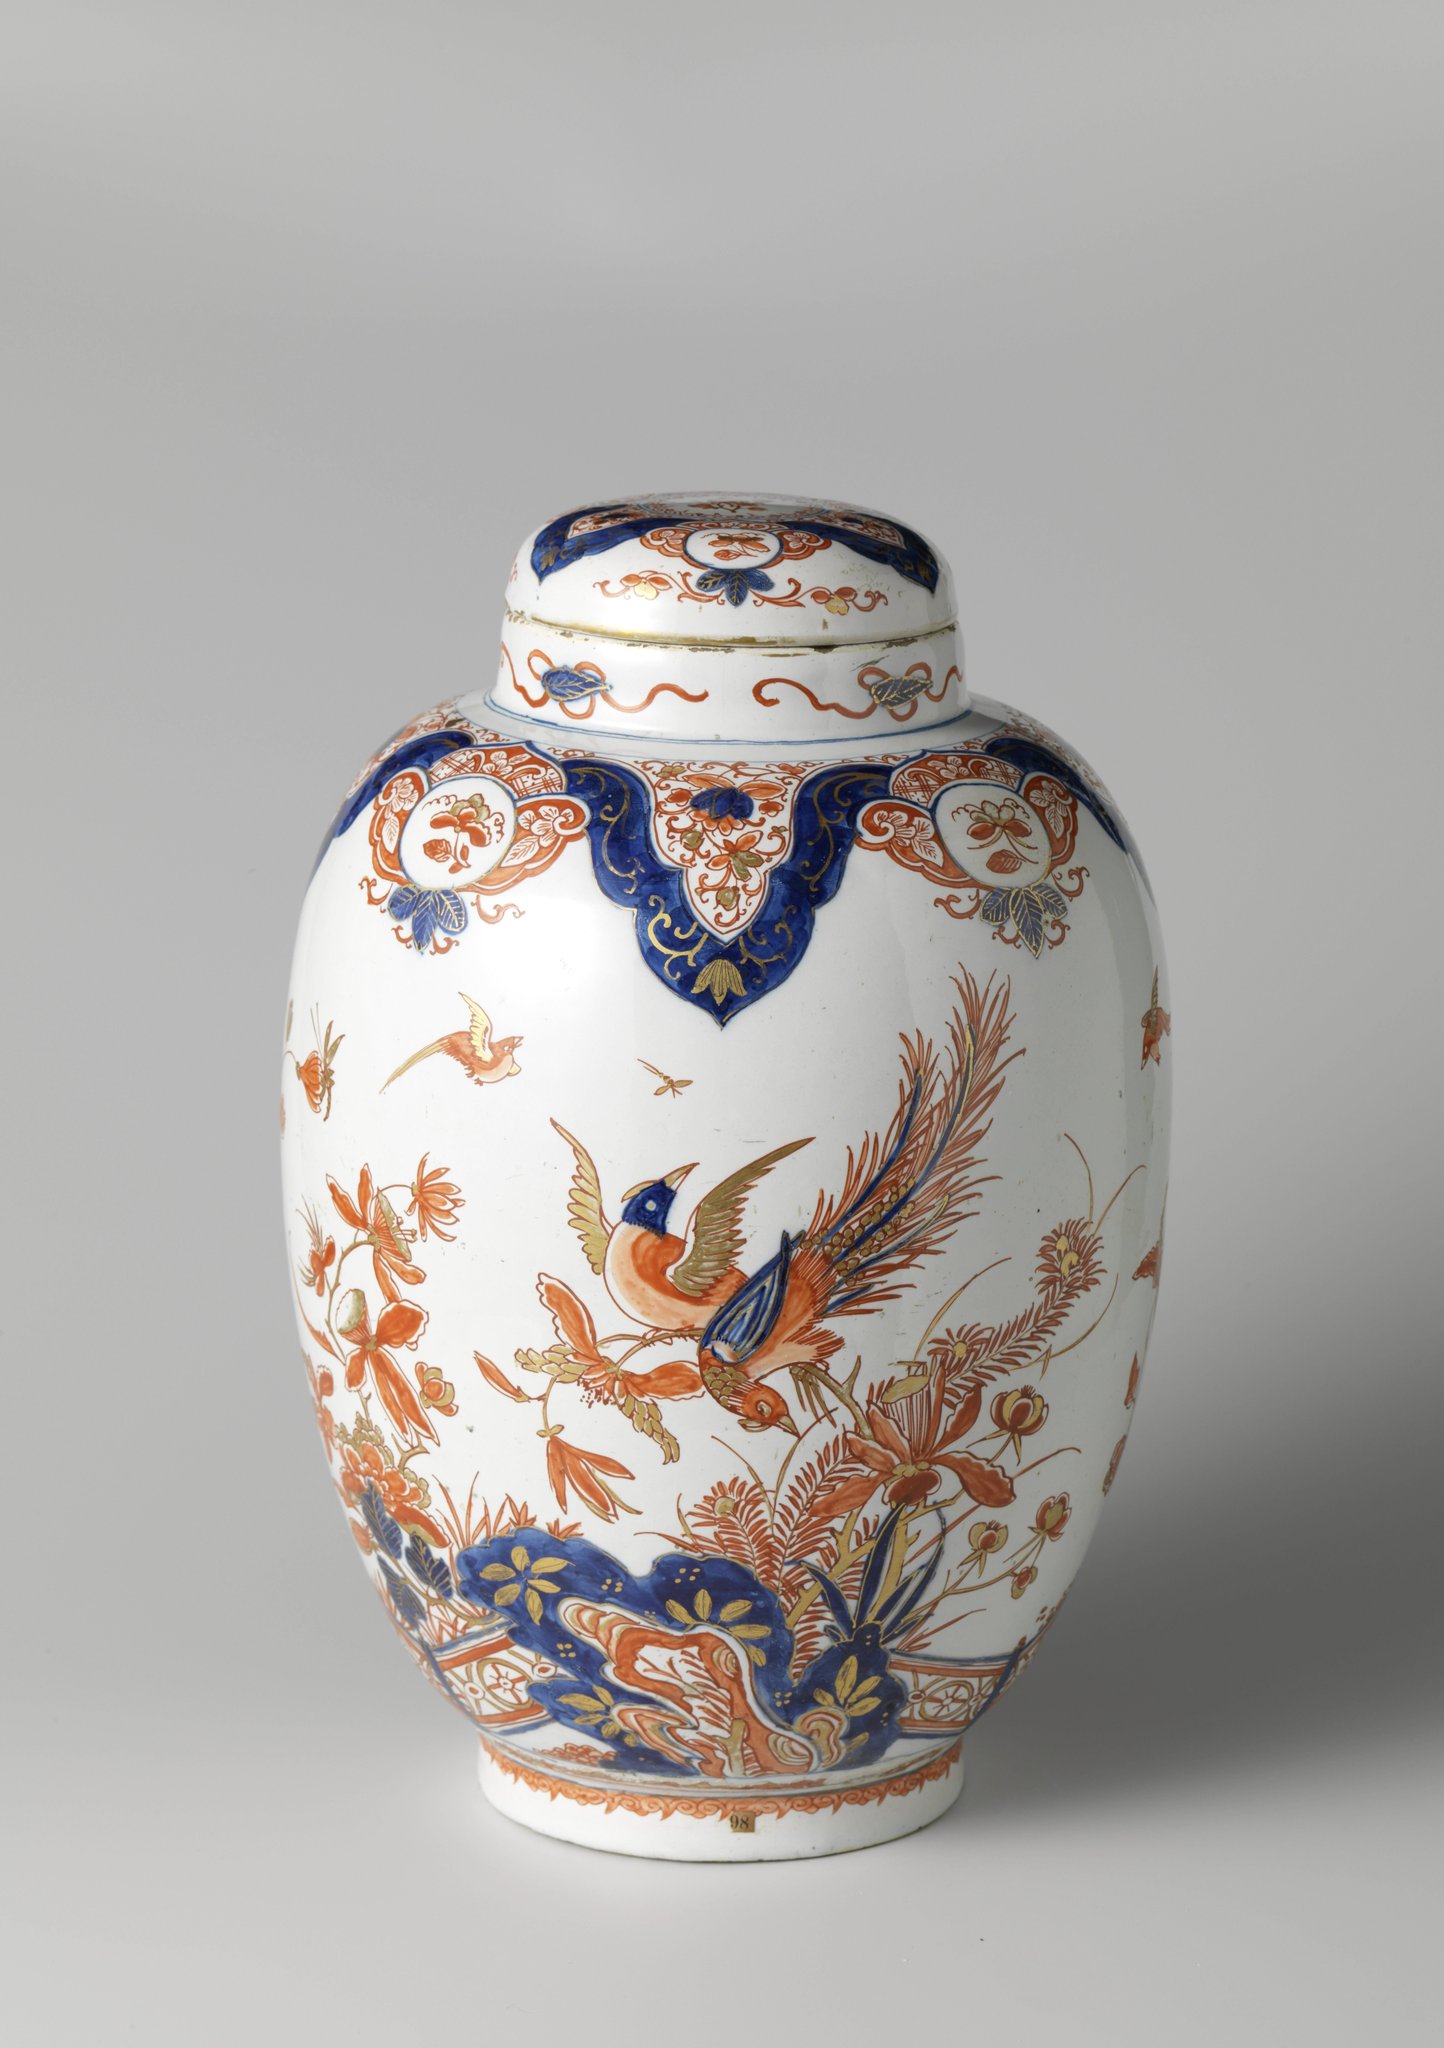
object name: covered jar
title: Pot met deksel van veelkleurig beschilderde faïence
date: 1700-1725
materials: faience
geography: delft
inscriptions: collector's mark: ‘collection J.F. Loudon’, mark: ‘APK (ineen)’, inscription: ‘53 en 53a(deksel)’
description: Pot van faïence met een platte deksel. Veelkleurig beschilderd met bloemtakken en vogels.